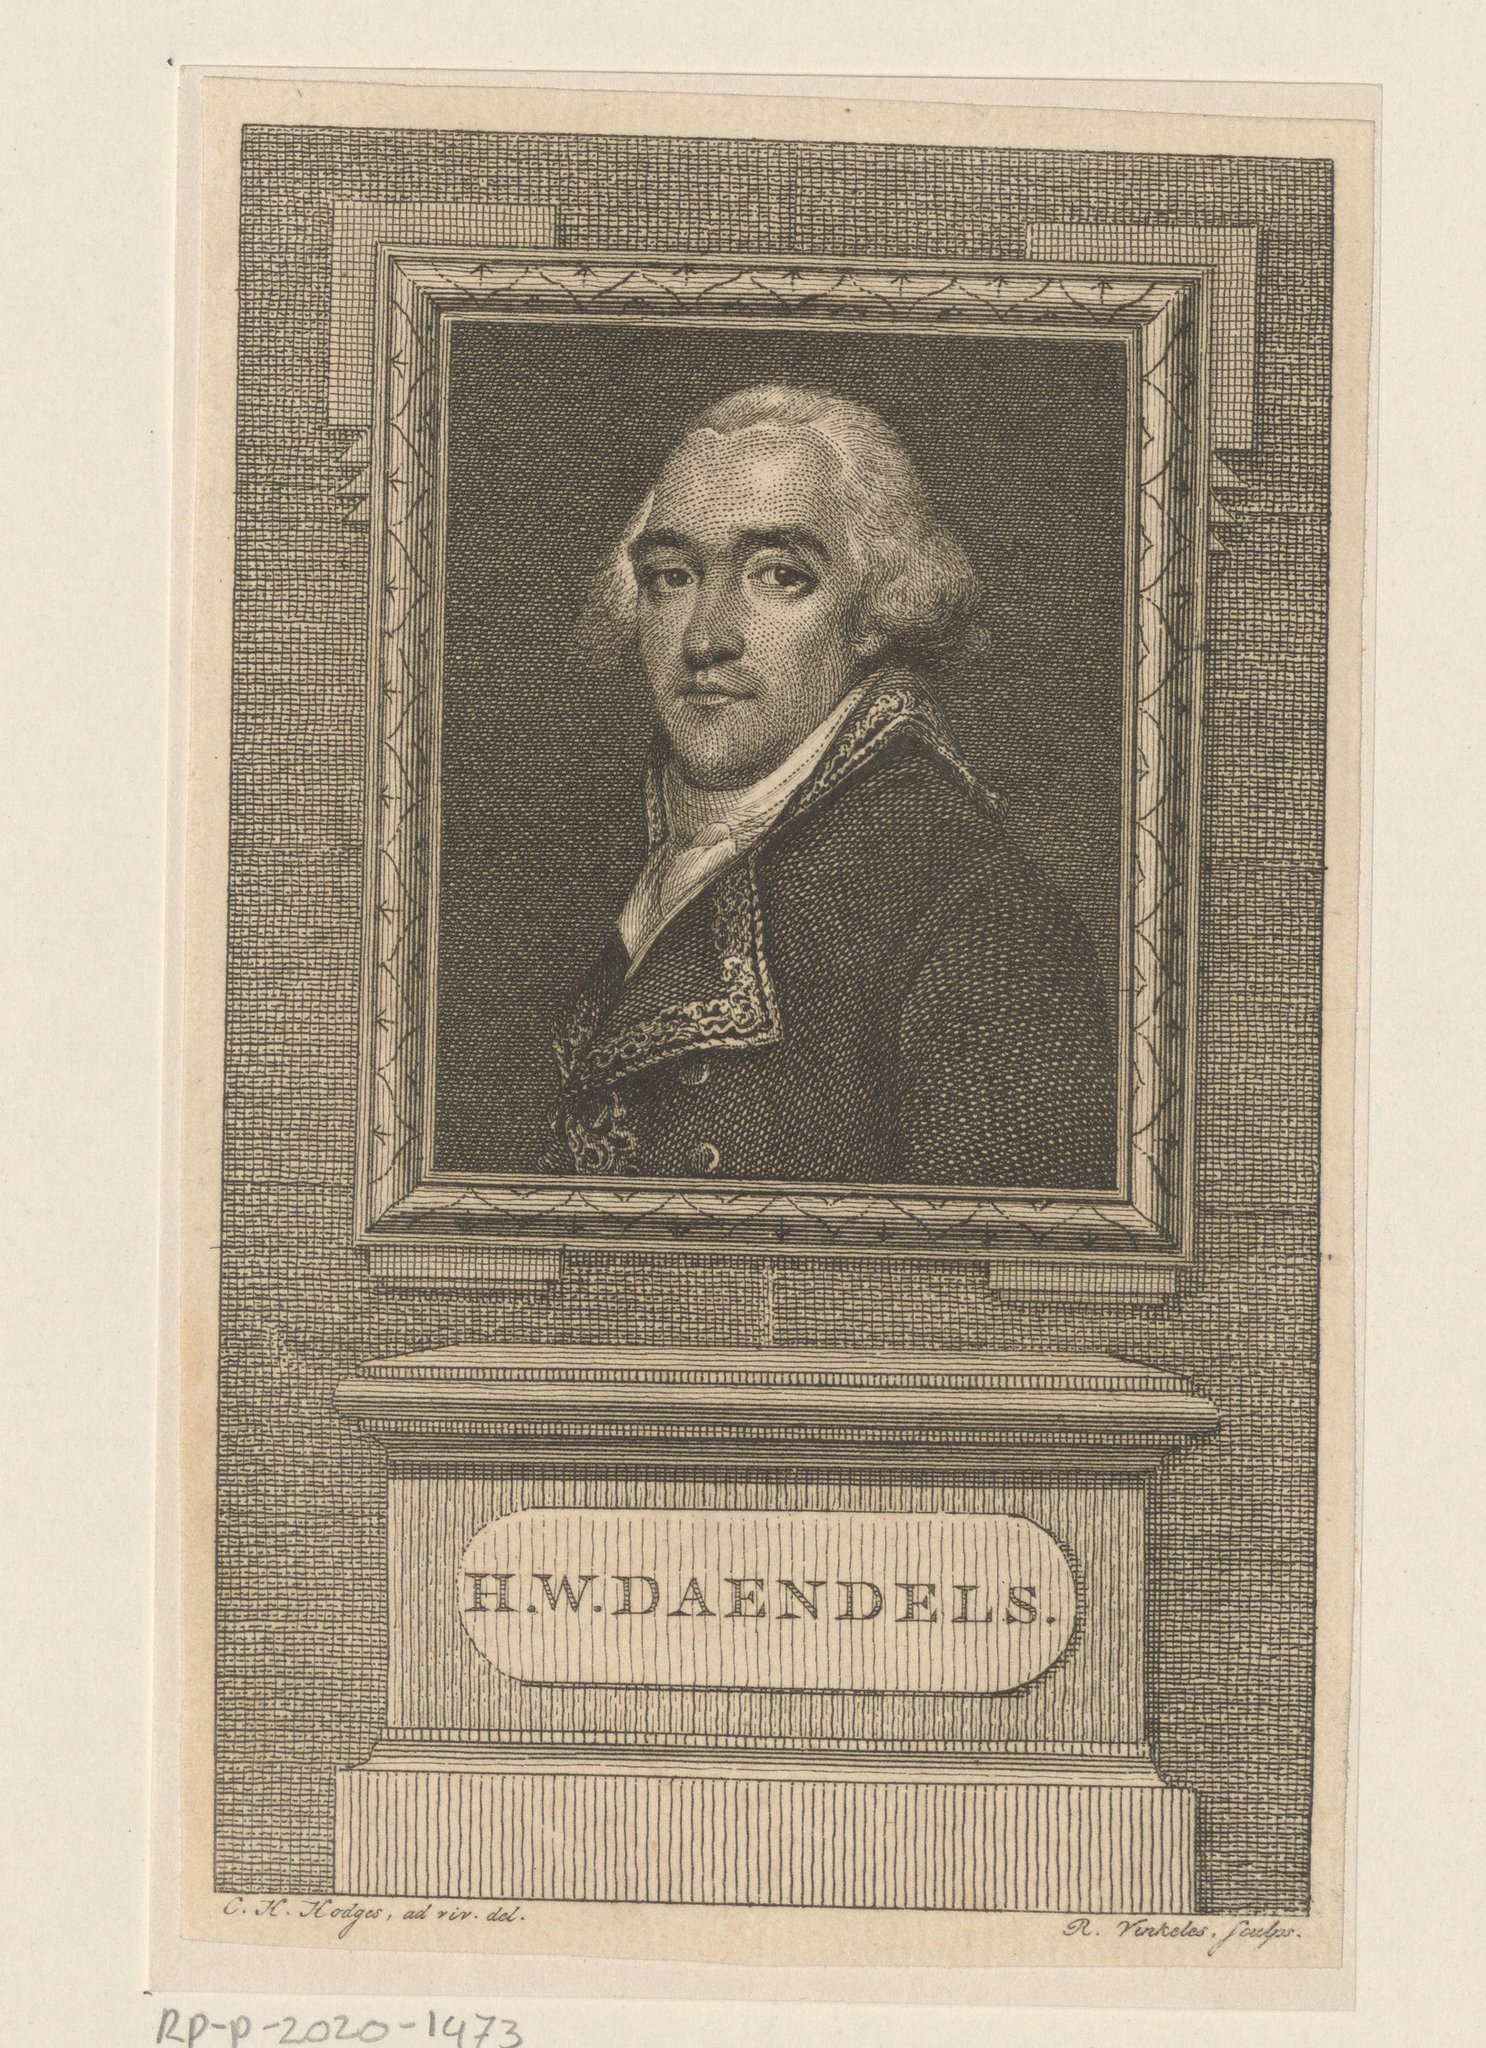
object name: print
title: Portret van Herman Willem Daendels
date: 1802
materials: paper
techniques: engraving, etching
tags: herman willem daendels, commander-in-chief, general, marshal, historical persons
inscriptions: collector's mark: Lugt 2228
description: Huidige staat van prent gebruikt in: Wagenaar, Jan. Vaderlandsche historie, vervattende de geschiedenissen der vereenigde Nederlanden (...). 43 dln. Amsterdam: Johannes Allart, 1802, dl. 29.